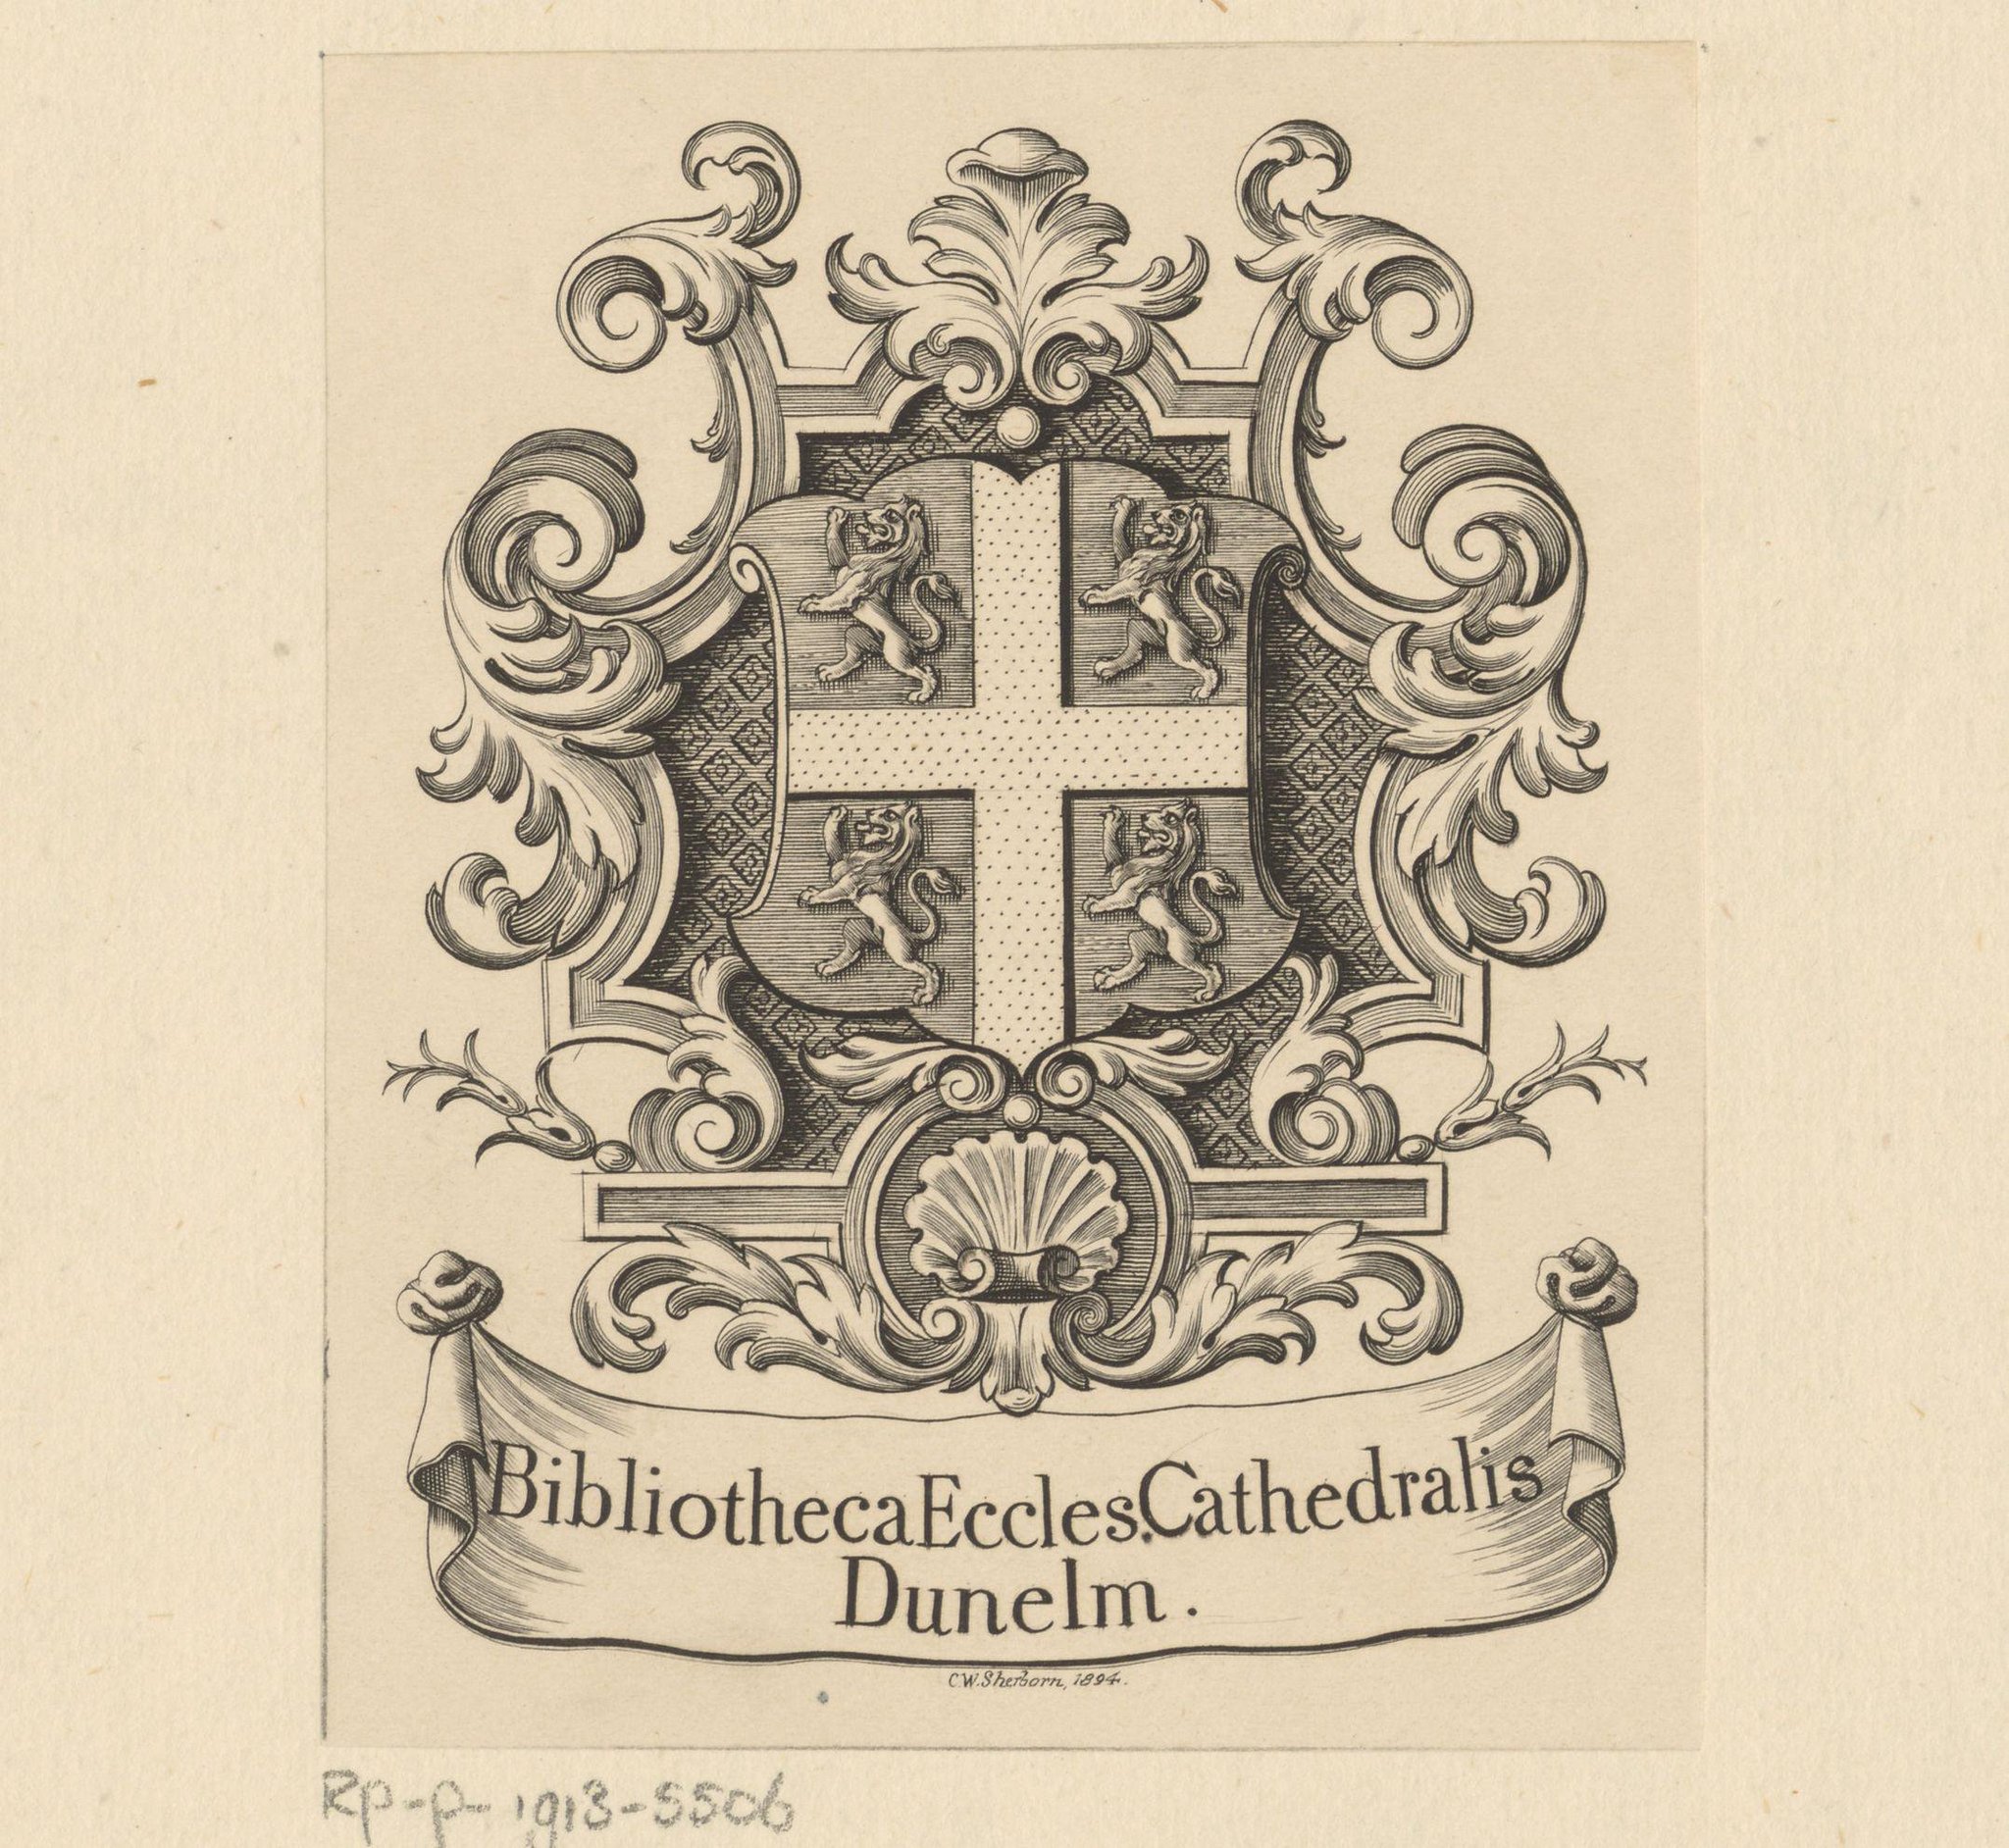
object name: bookplate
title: Ex libris van Bibliotheca Eccles. Cathedralis Dunelm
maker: charles william sherborn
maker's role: print maker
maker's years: 1831-1912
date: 1894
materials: paper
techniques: engraving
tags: armorial bearing, heraldry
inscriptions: collector's mark: Lugt 2233, collector's mark: Lugt 2760